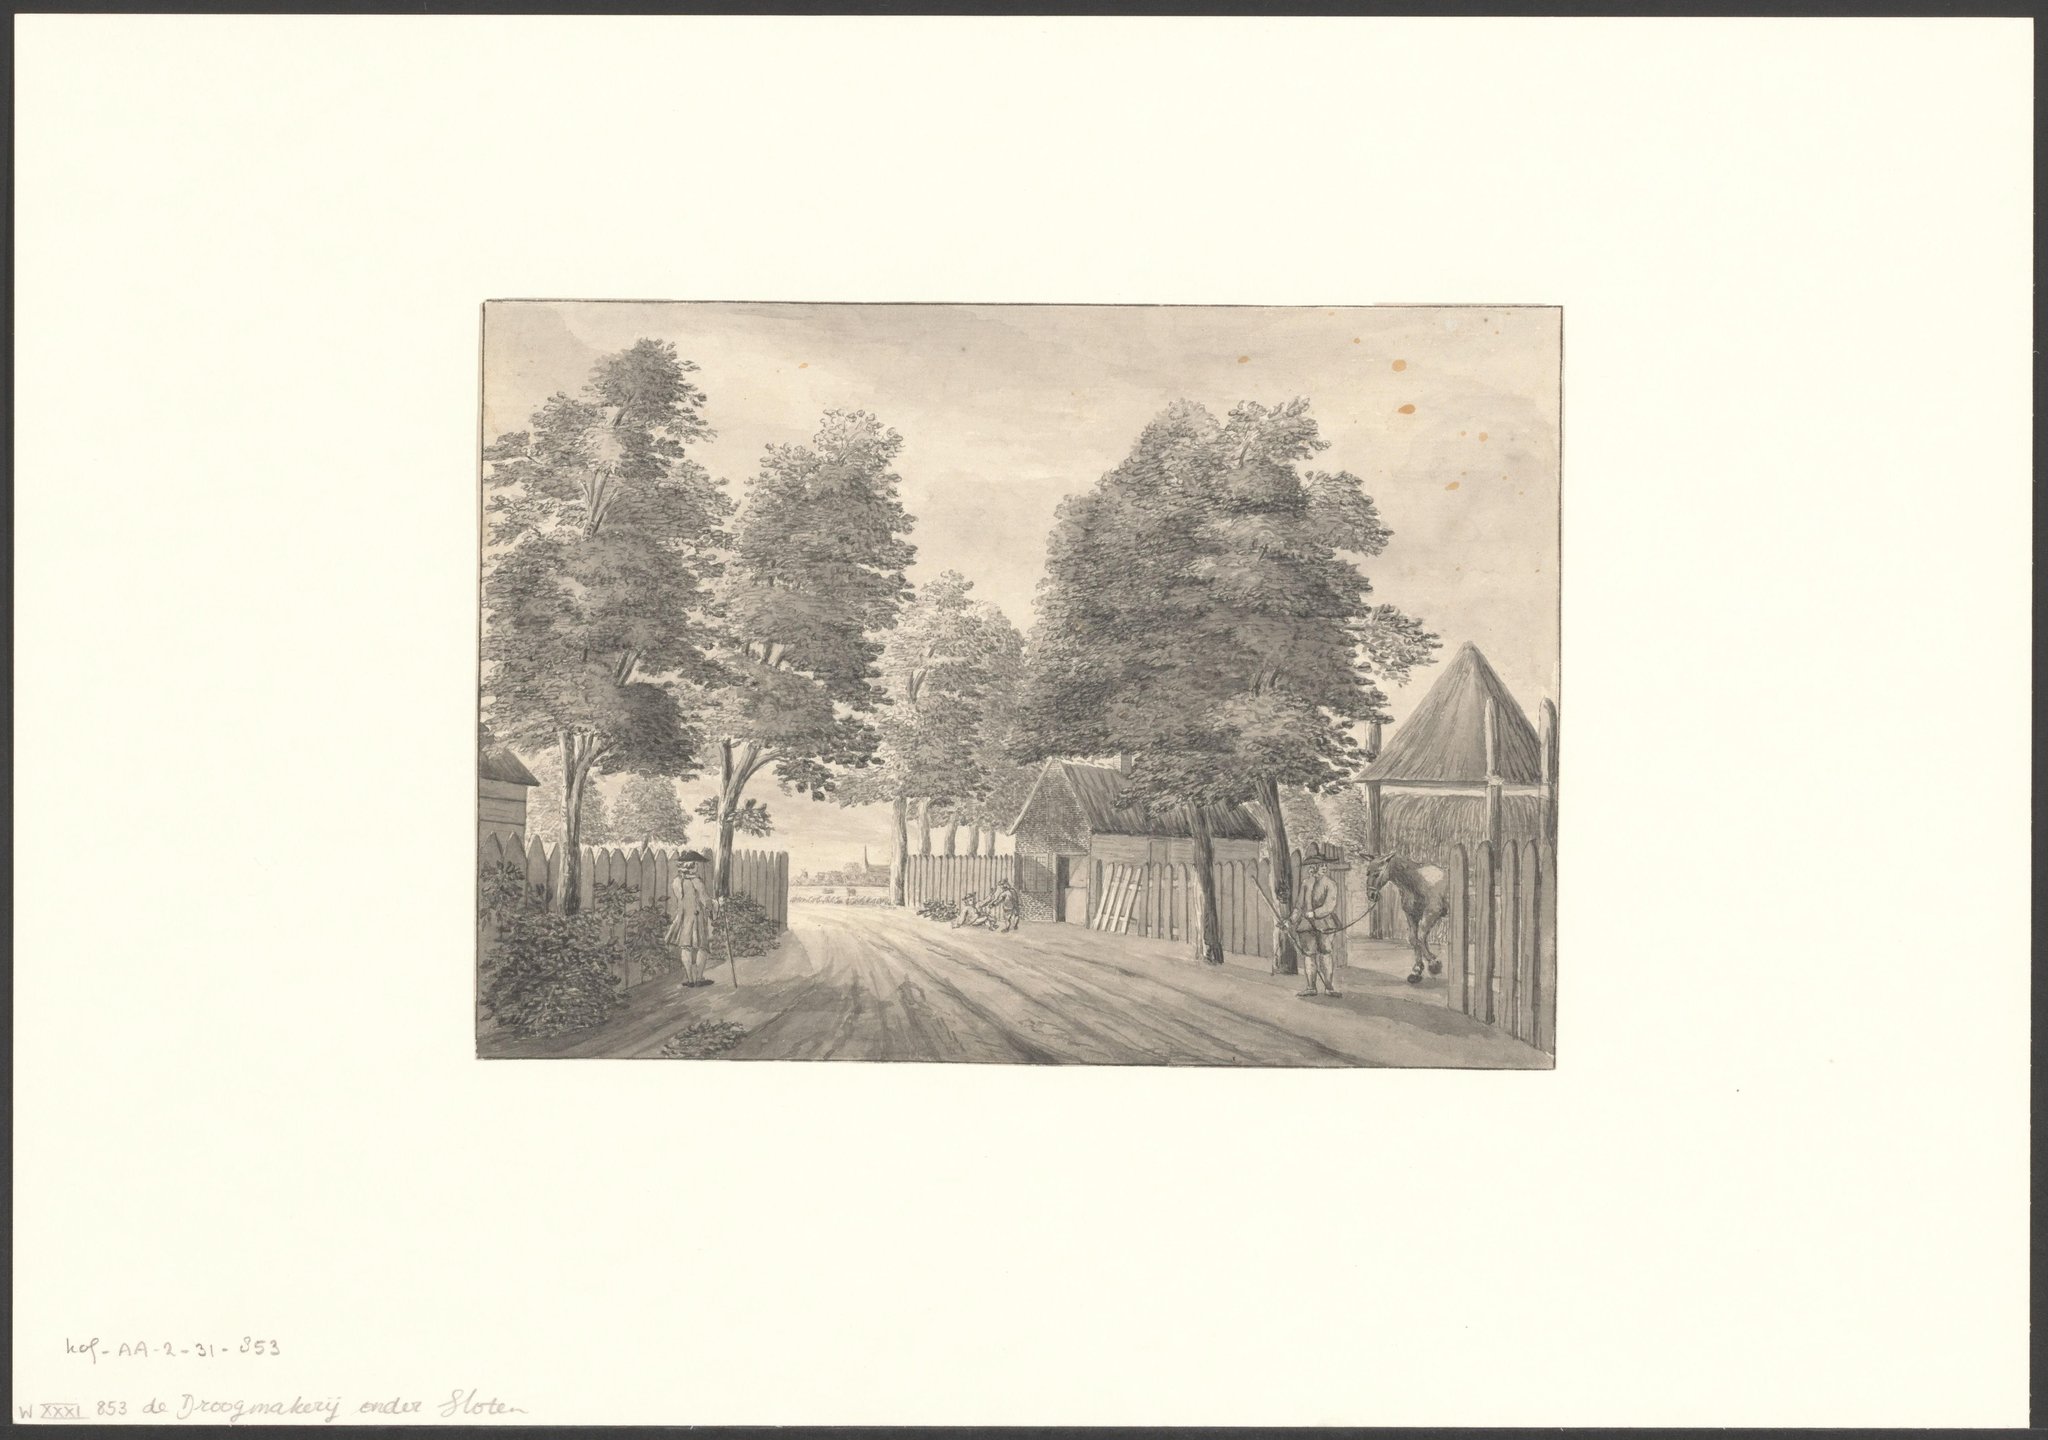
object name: drawing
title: Gezicht op een weg in Sloten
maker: jan spaan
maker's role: print maker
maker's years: 1742-1828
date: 1752-1828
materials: ink, paper, pencil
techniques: brush, pen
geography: amsterdam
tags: city-view in general; 'veduta', road, path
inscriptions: signature: ‘J.Spaan. / del & fec.’, collector's mark: Lugt 800a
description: Tekening binnen de Atlas Van Eck ingedeeld op wijknummer 31.